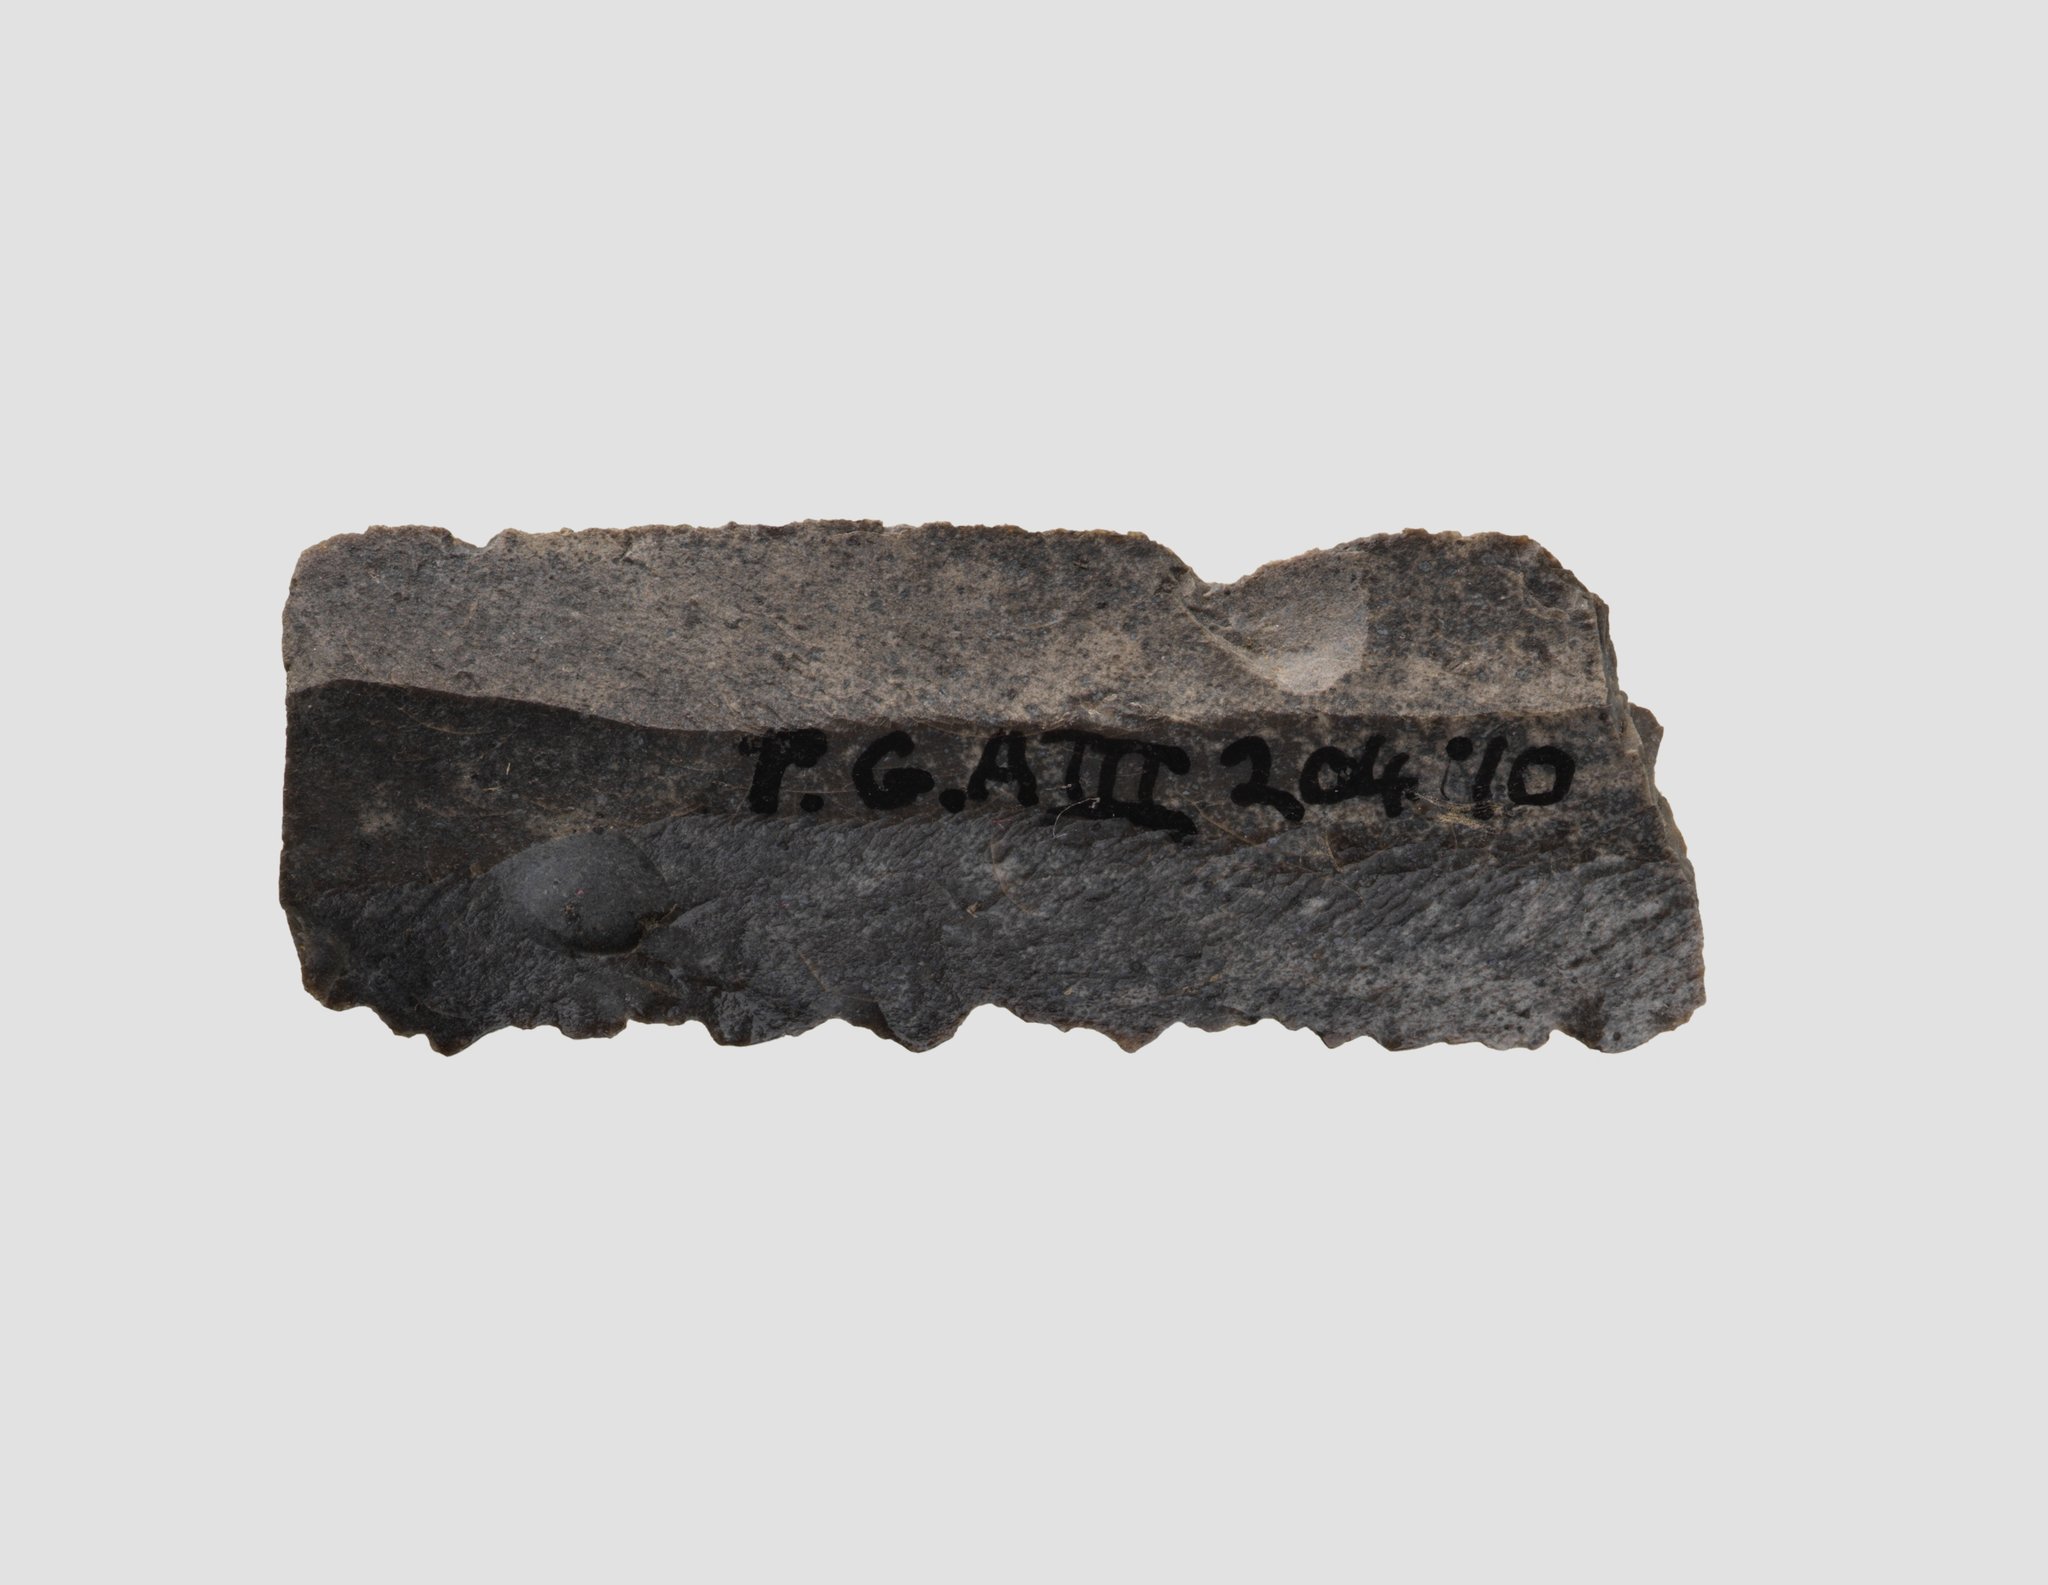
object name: knife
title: Blade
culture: ghassulian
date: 4600-3600 BCE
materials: stone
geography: levant